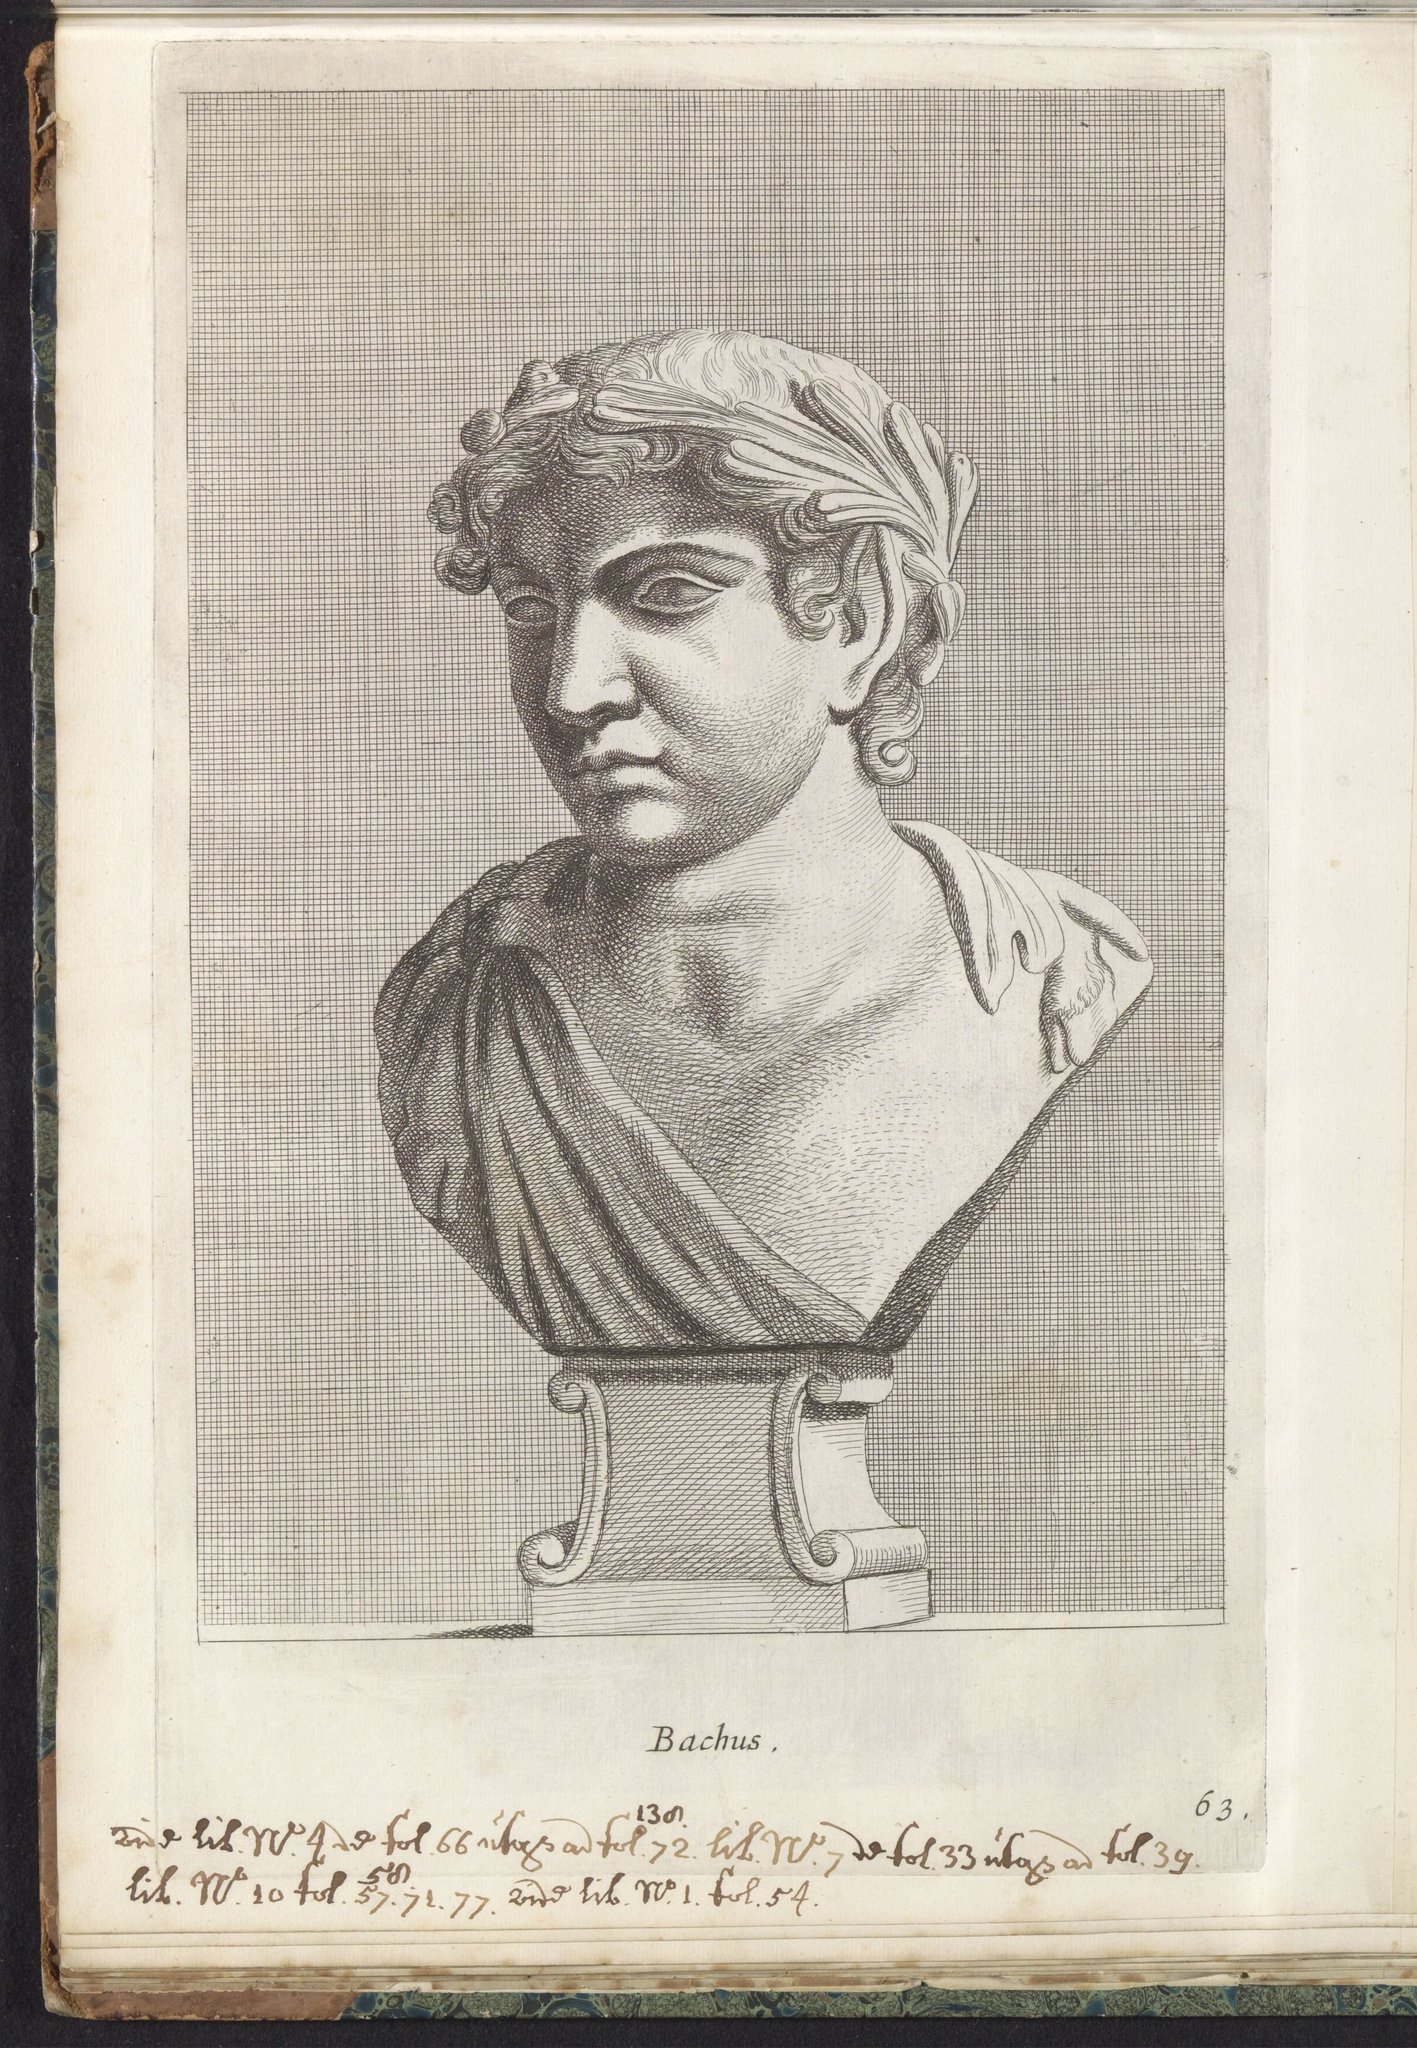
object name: print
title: Buste van Bacchus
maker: hubert quellinus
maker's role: print maker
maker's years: 1619-1687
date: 1646-1670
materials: paper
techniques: engraving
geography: antwerp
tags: (story of) bacchus (dionysus), liber, (story of) pan, piece of sculpture, reproduction of a piece of sculpture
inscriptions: number: ‘71’, inscription: ‘Vide lib. No. 4 de fol. 66 ...’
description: Klassieke buste van de god Bacchus of Pan, met een kroon van bladeren en twee bokkenpoten over zijn schouders. De prent maakt deel uit van een album met een serie prenten naar de sculpturen in de verzameling van Gerard Reynst.